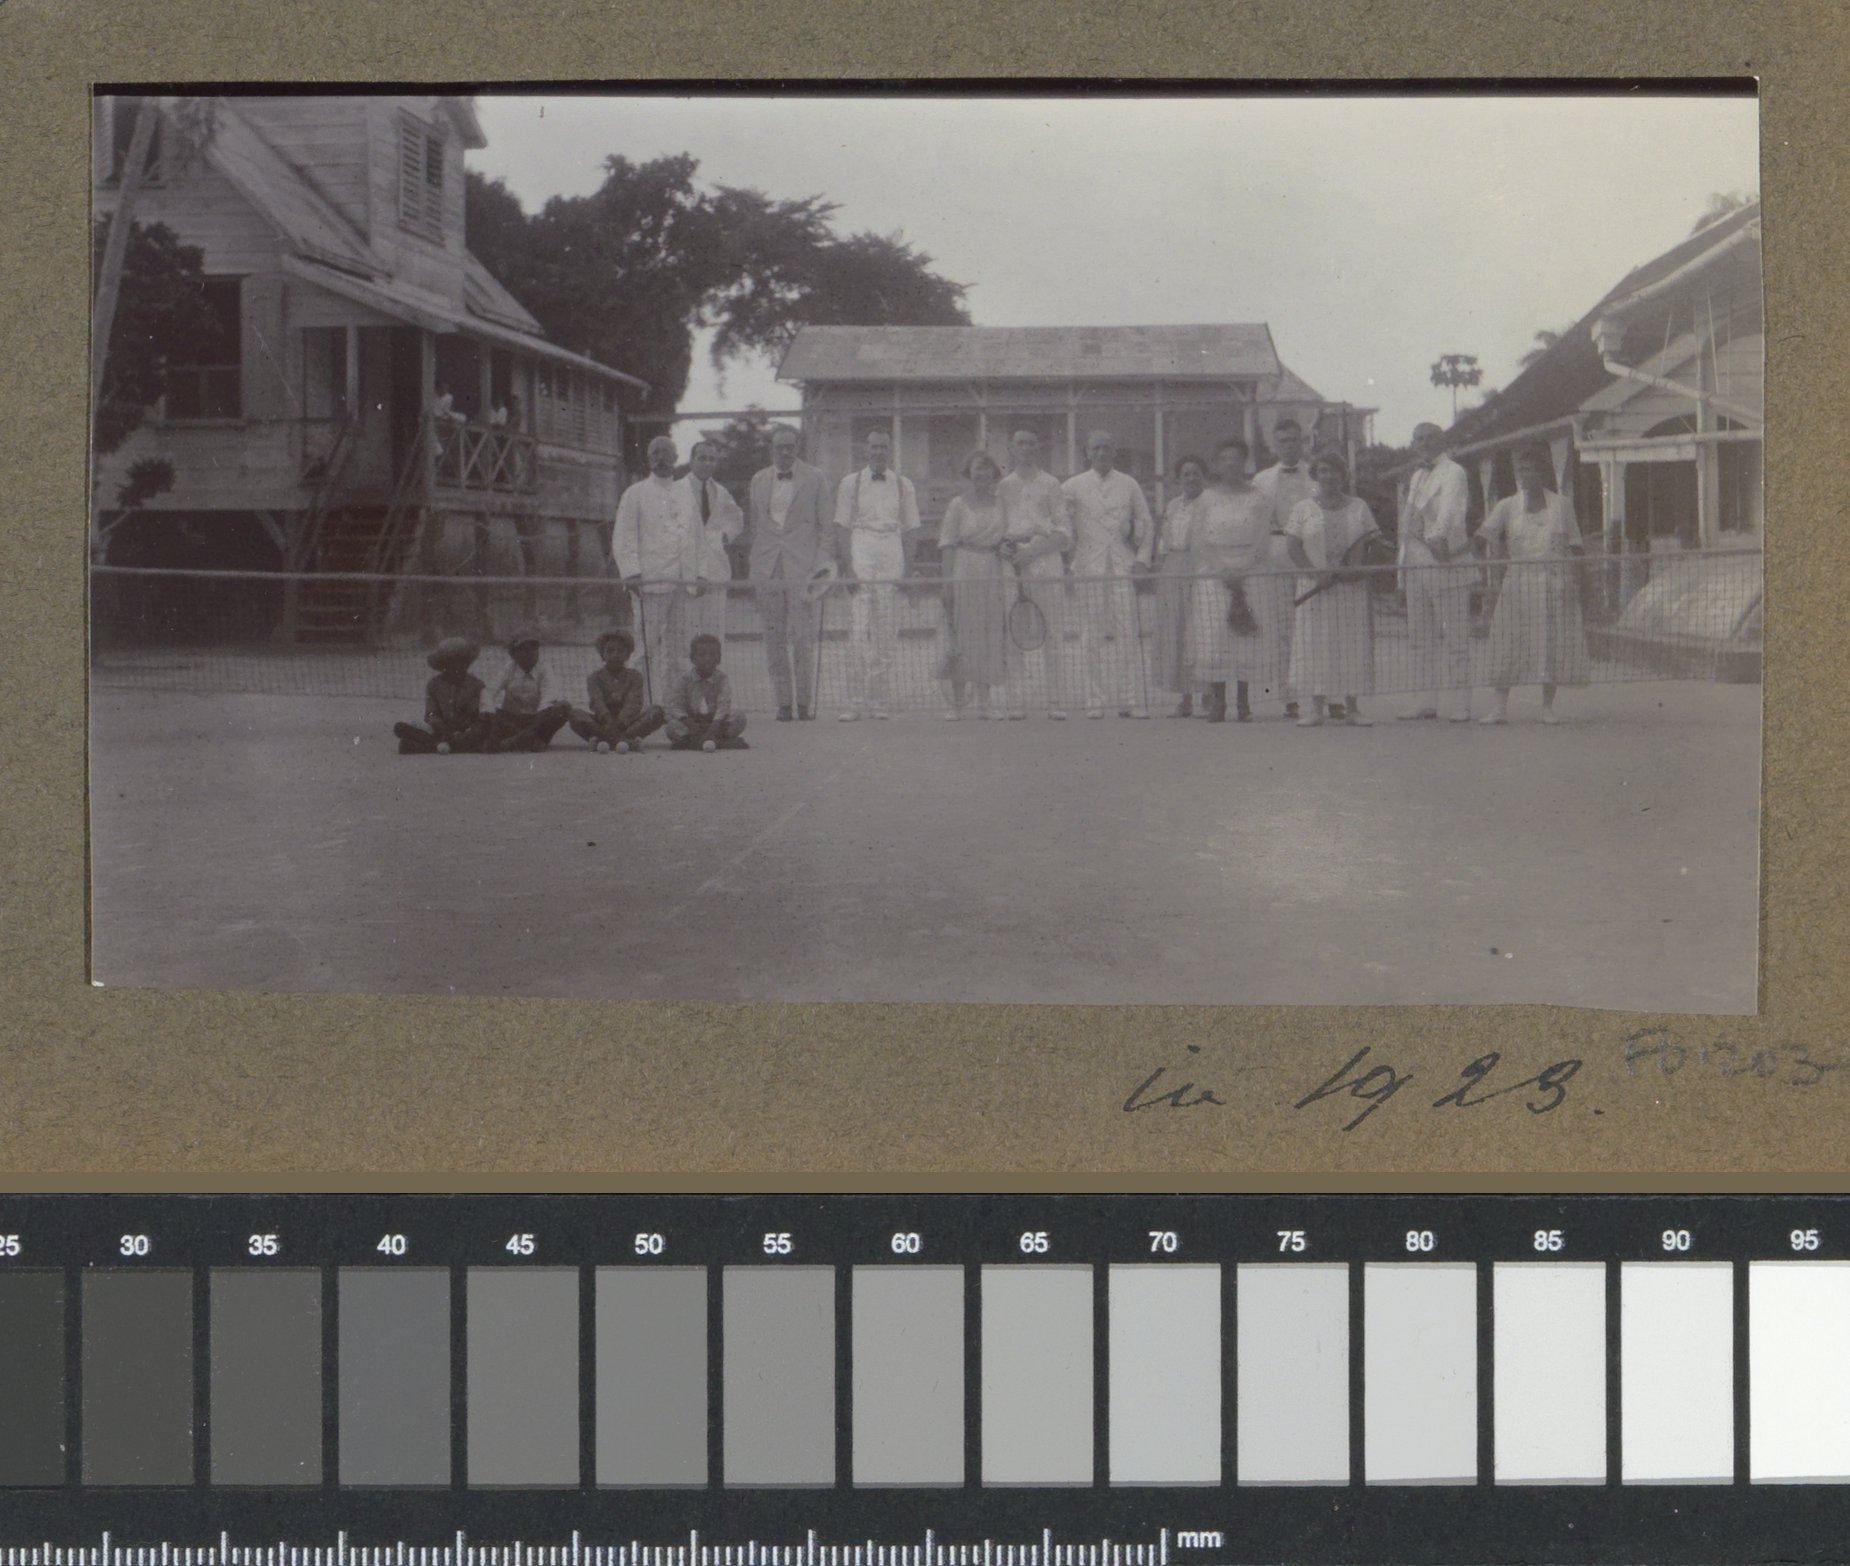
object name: photograph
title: in 1923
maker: Anonymous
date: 1923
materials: photographic support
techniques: gelatin silver print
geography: suriname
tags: adult woman, tennis, lawn-tennis (+ sportsman, player, etc.), adult man, suriname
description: Onderdeel van fotoalbum van een onbekende Nederlandse familie met opnames van Suriname, Europa en Nederlands-Indië.